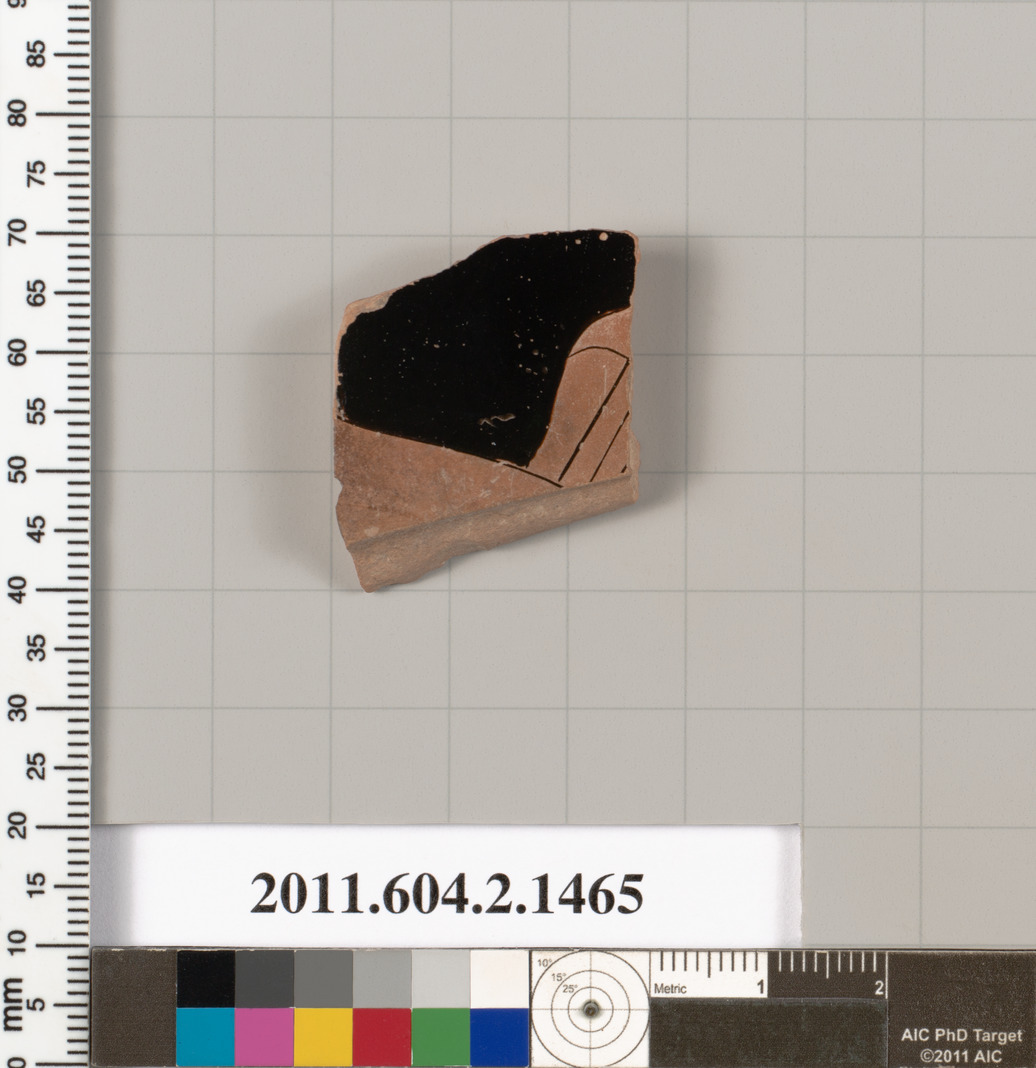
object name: skyphos fragment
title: Terracotta fragment of a skyphos (deep drinking cup)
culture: greek, attic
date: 450-401 BCE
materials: terracotta